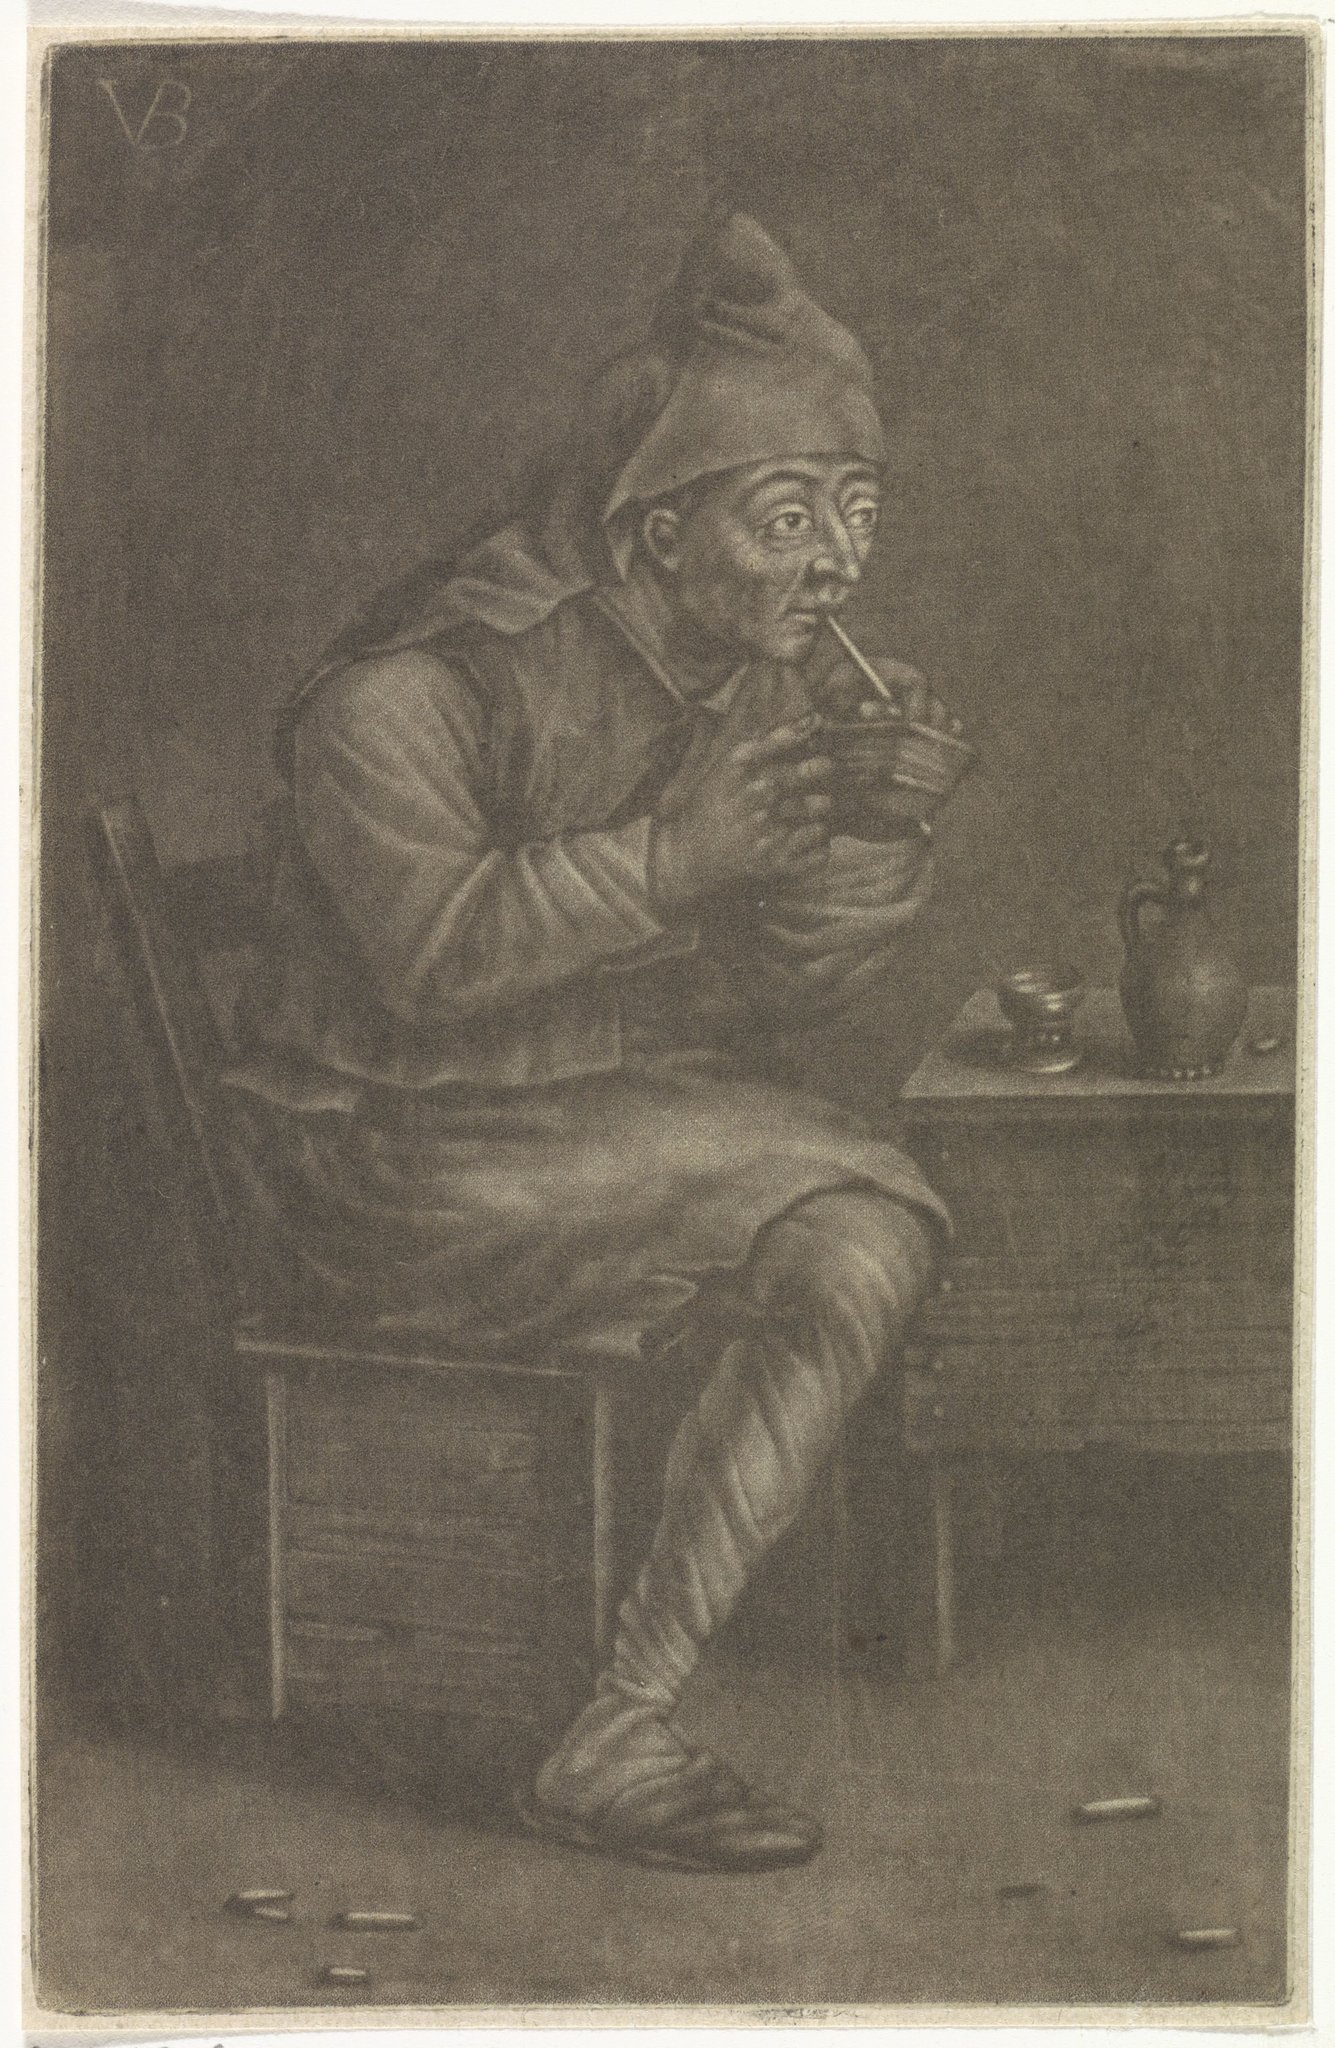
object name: print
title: Man steekt zijn pijp aan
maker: jan van der bruggen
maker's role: draughtsman, print maker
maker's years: 1649-1709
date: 1659-1740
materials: paper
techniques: mezzotint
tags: pipe ~ tobacco, jar, jug (used as drinking-vessel)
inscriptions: collector's mark: Lugt 2228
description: Een man zit op een stoel voor een tafeltje waarop een kruik en een glas. Hij steekt zijn pijp aan.